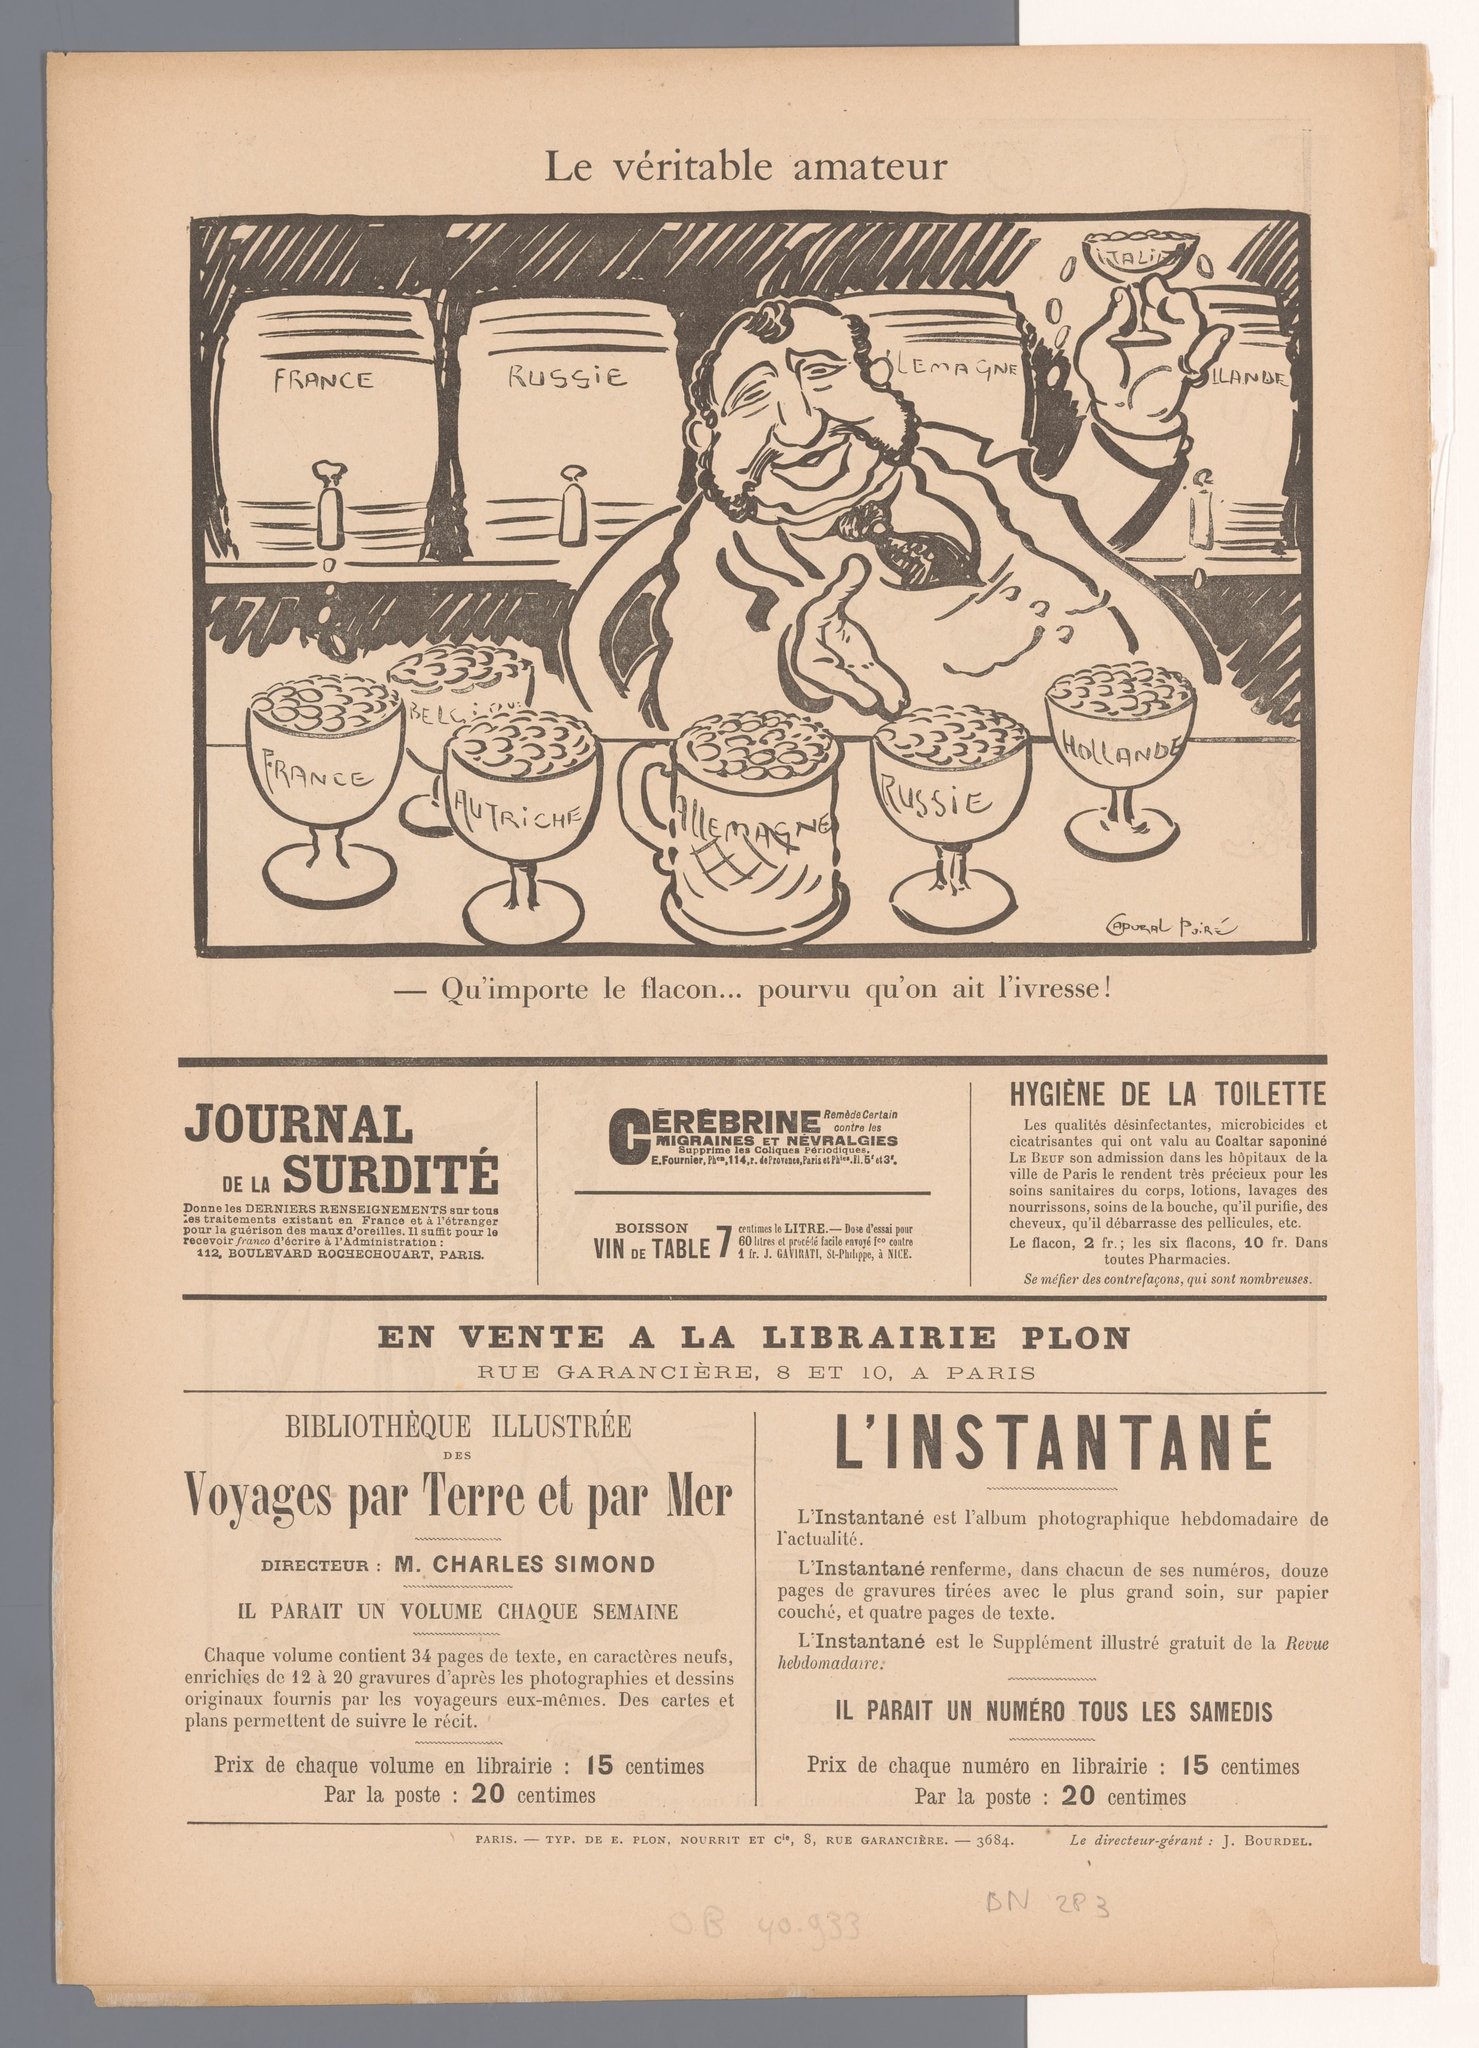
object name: cartoon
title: Figuur biedt steekpenningen aan uit diverse Europese landen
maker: jean-louis forain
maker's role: painter, print maker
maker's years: 1852-1931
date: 1898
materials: paper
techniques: lithograph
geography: paris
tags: drunkenness, bribery, political caricatures and satires, money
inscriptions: date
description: Prent gebruikt voor: Psst...!, nr. 9, 2 april 1898. Psst..! was een politieke weekkrant met antisemitische en anti-Dreyfus cartoons.